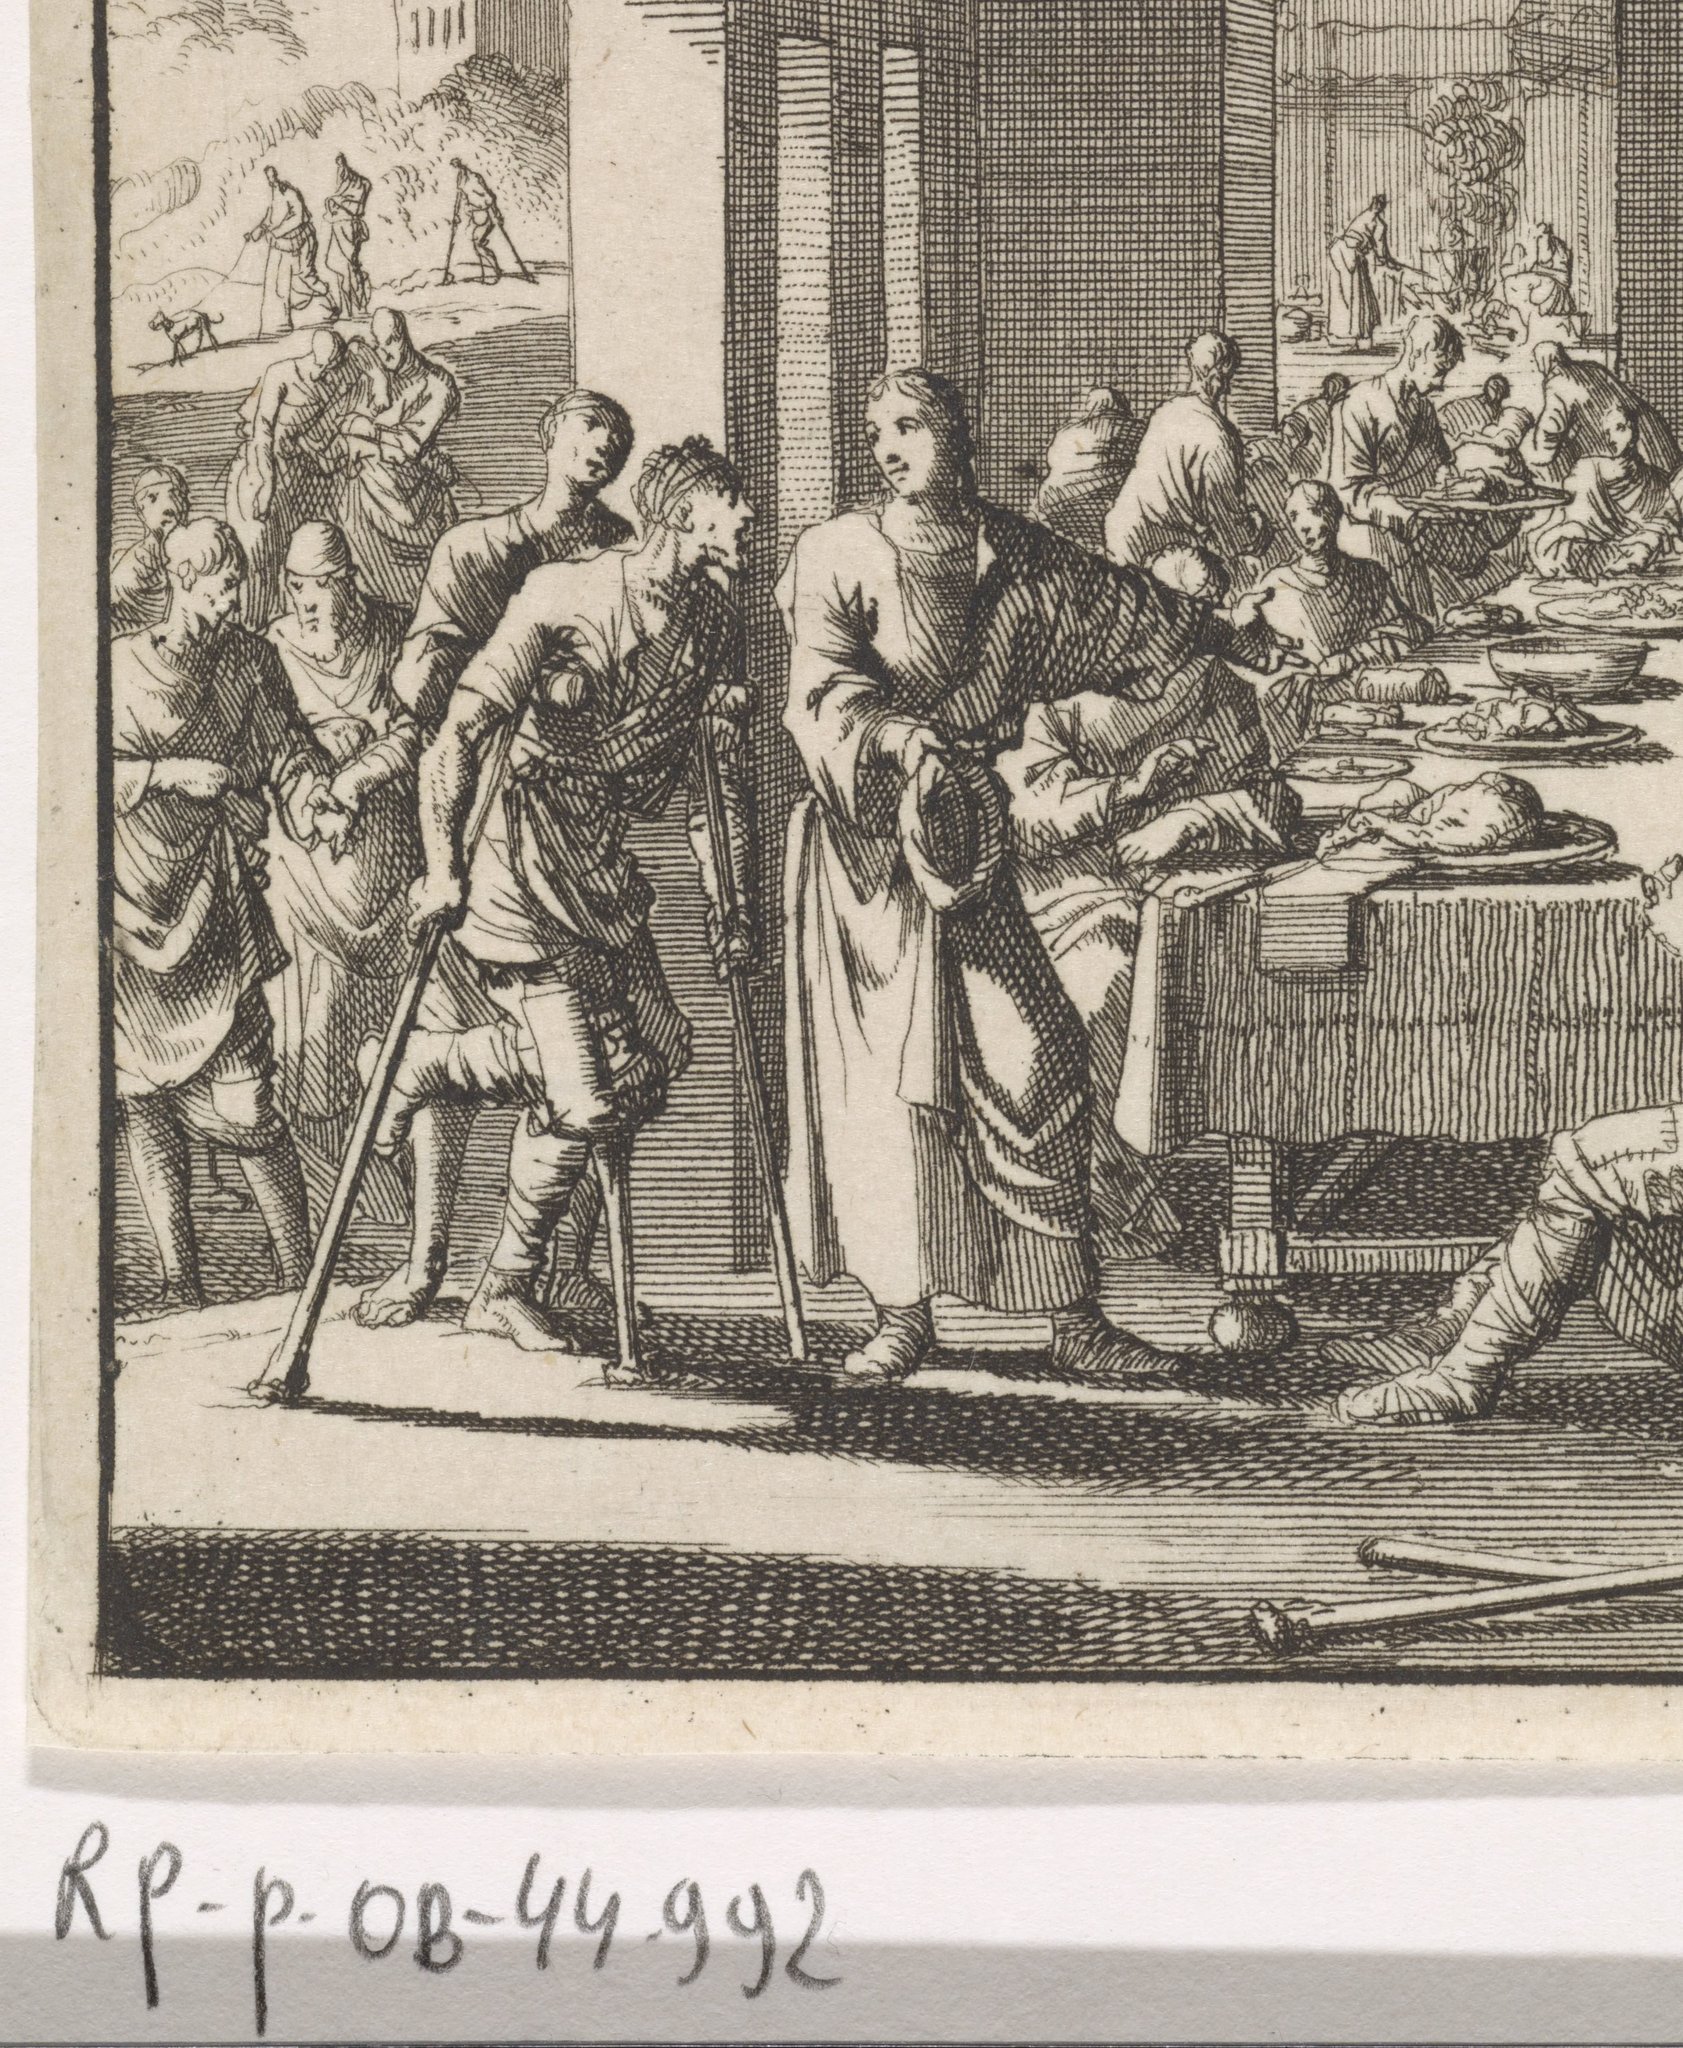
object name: book illustration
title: Maaltijd voor de armen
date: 1700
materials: paper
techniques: etching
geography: amsterdam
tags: disabilities, deformations, feeding the hungry, 'esuriens cibatur' ~ one of the (seven) acts of mercy, charitable works, the poor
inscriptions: collector's mark: Lugt 2228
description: Een man nodigt arme mensen, waaronder mensen met beperkingen, uit om zijn woonst te betreden en aan een tafel te gaan zitten waar men eten voor hen opdient.